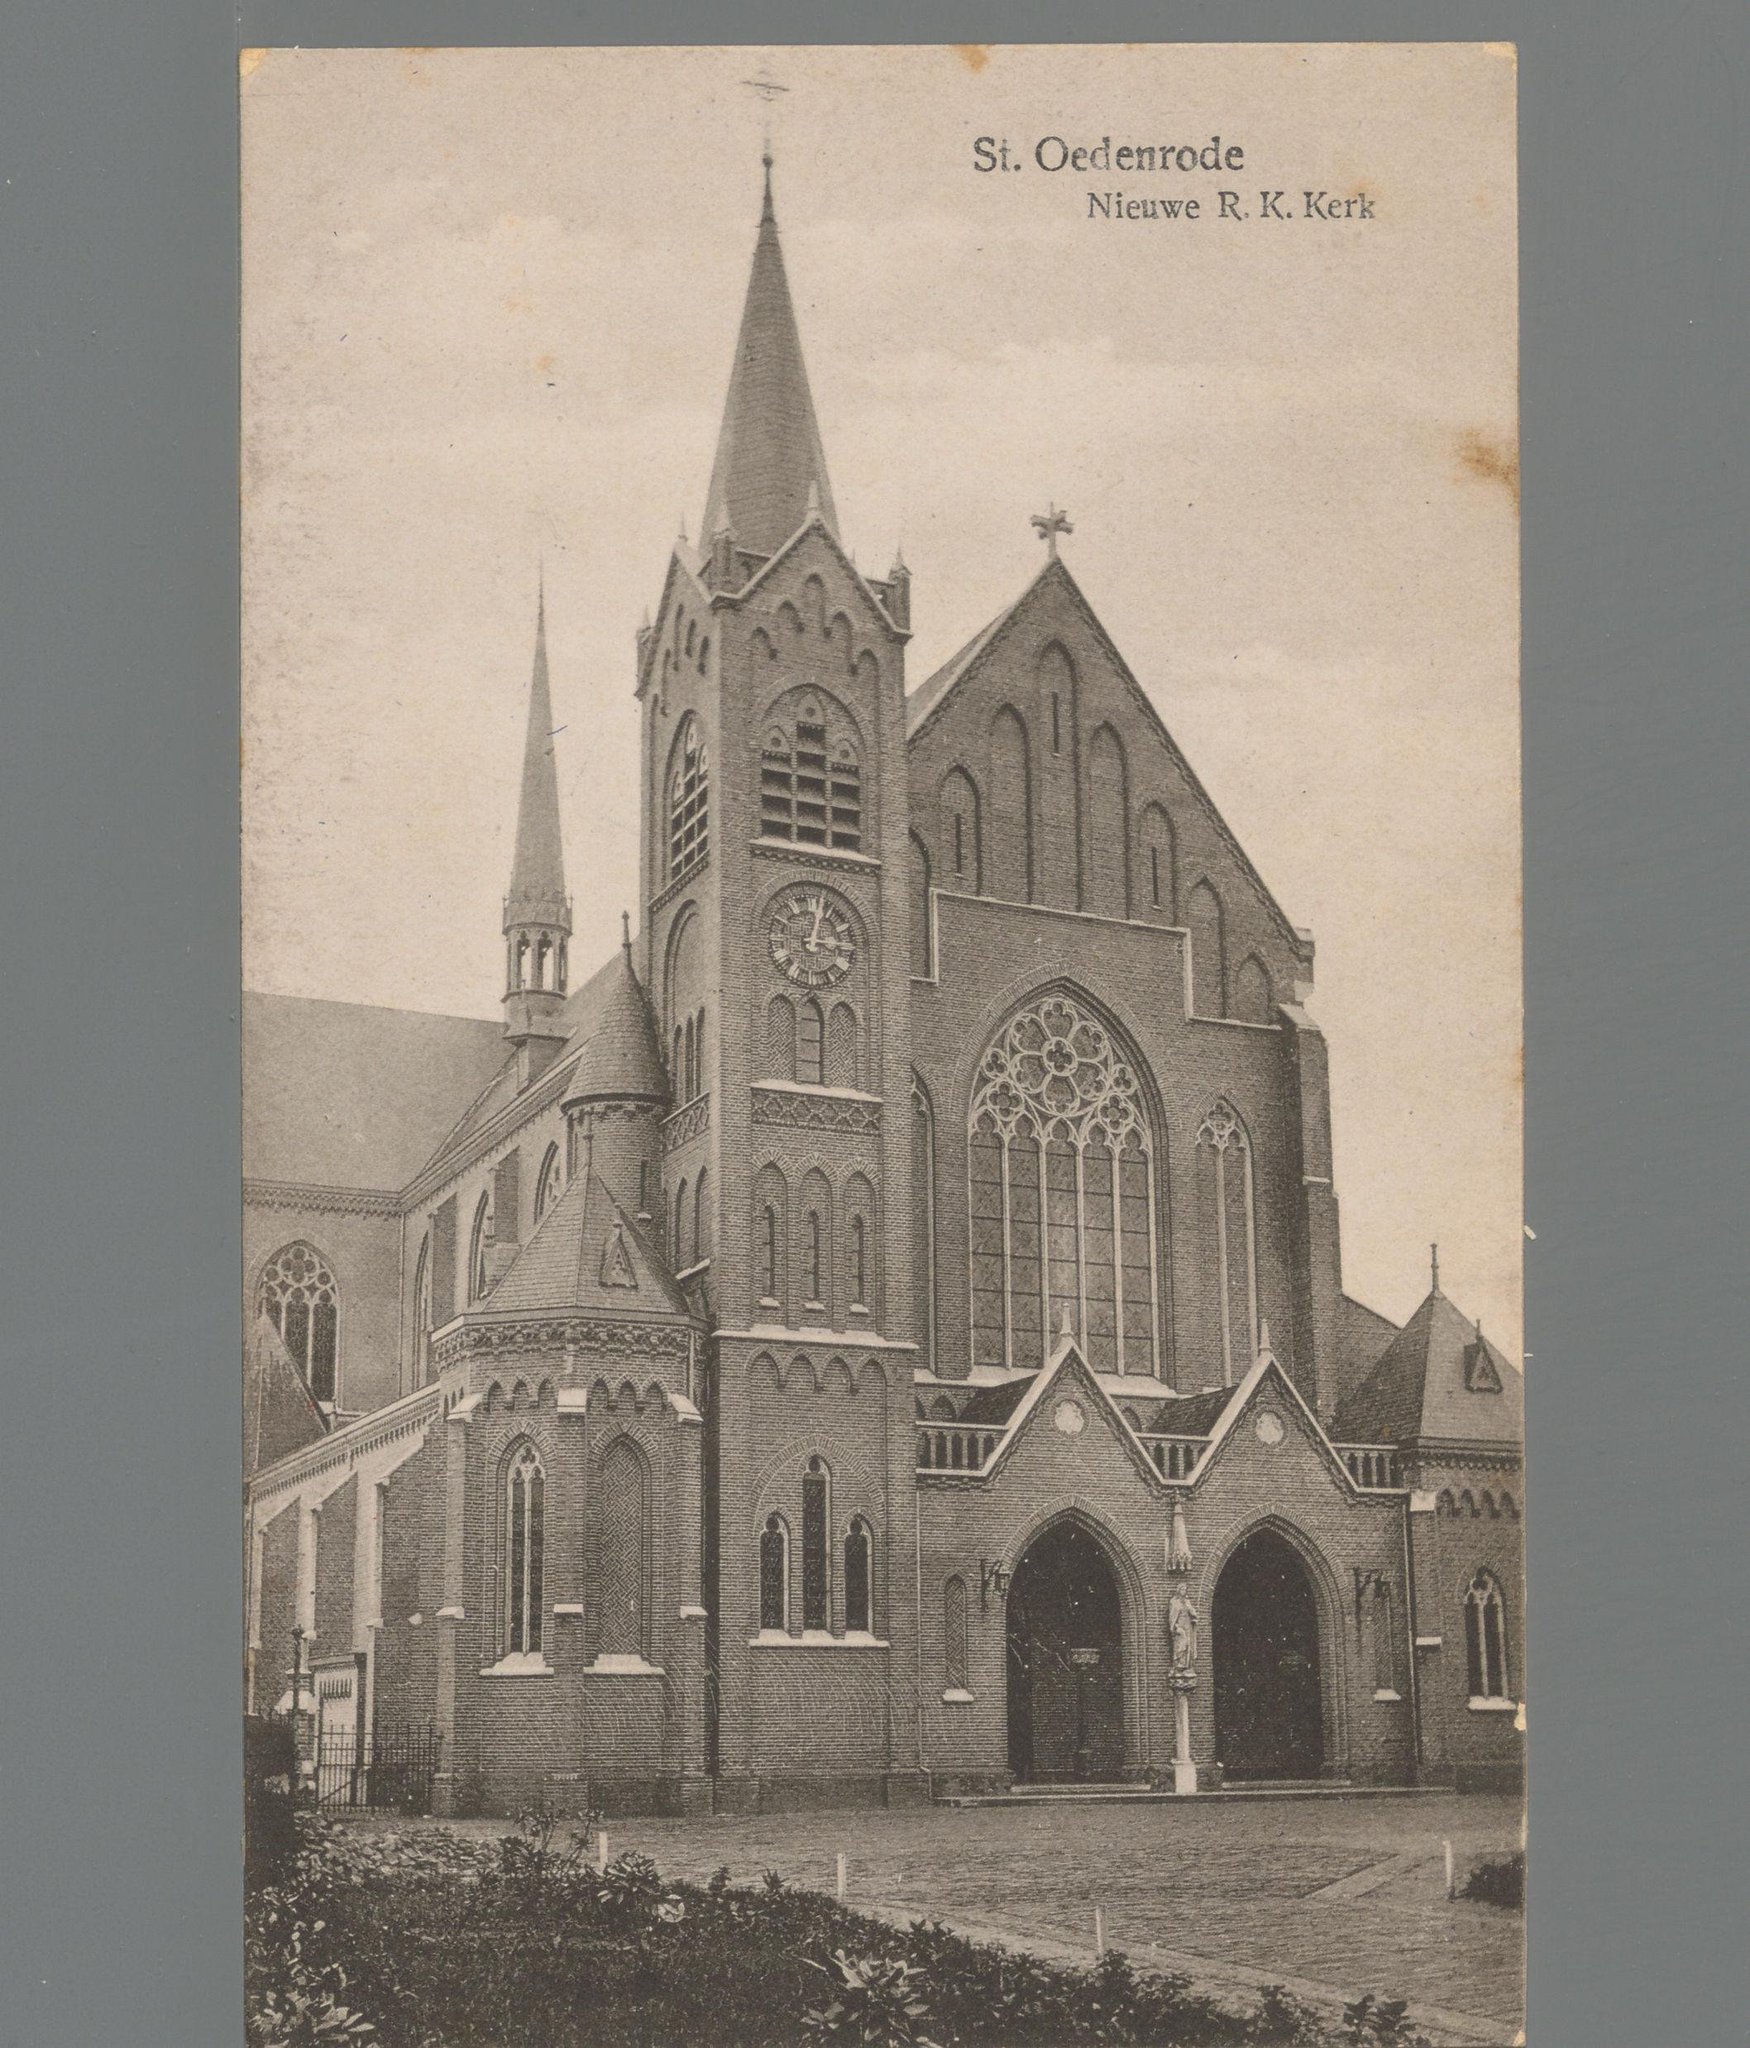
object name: photomechanical print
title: St. Oedenrode. Nieuwe R. K. Kerk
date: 1920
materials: cardboard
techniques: photograph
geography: waalre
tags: church (exterior)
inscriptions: date